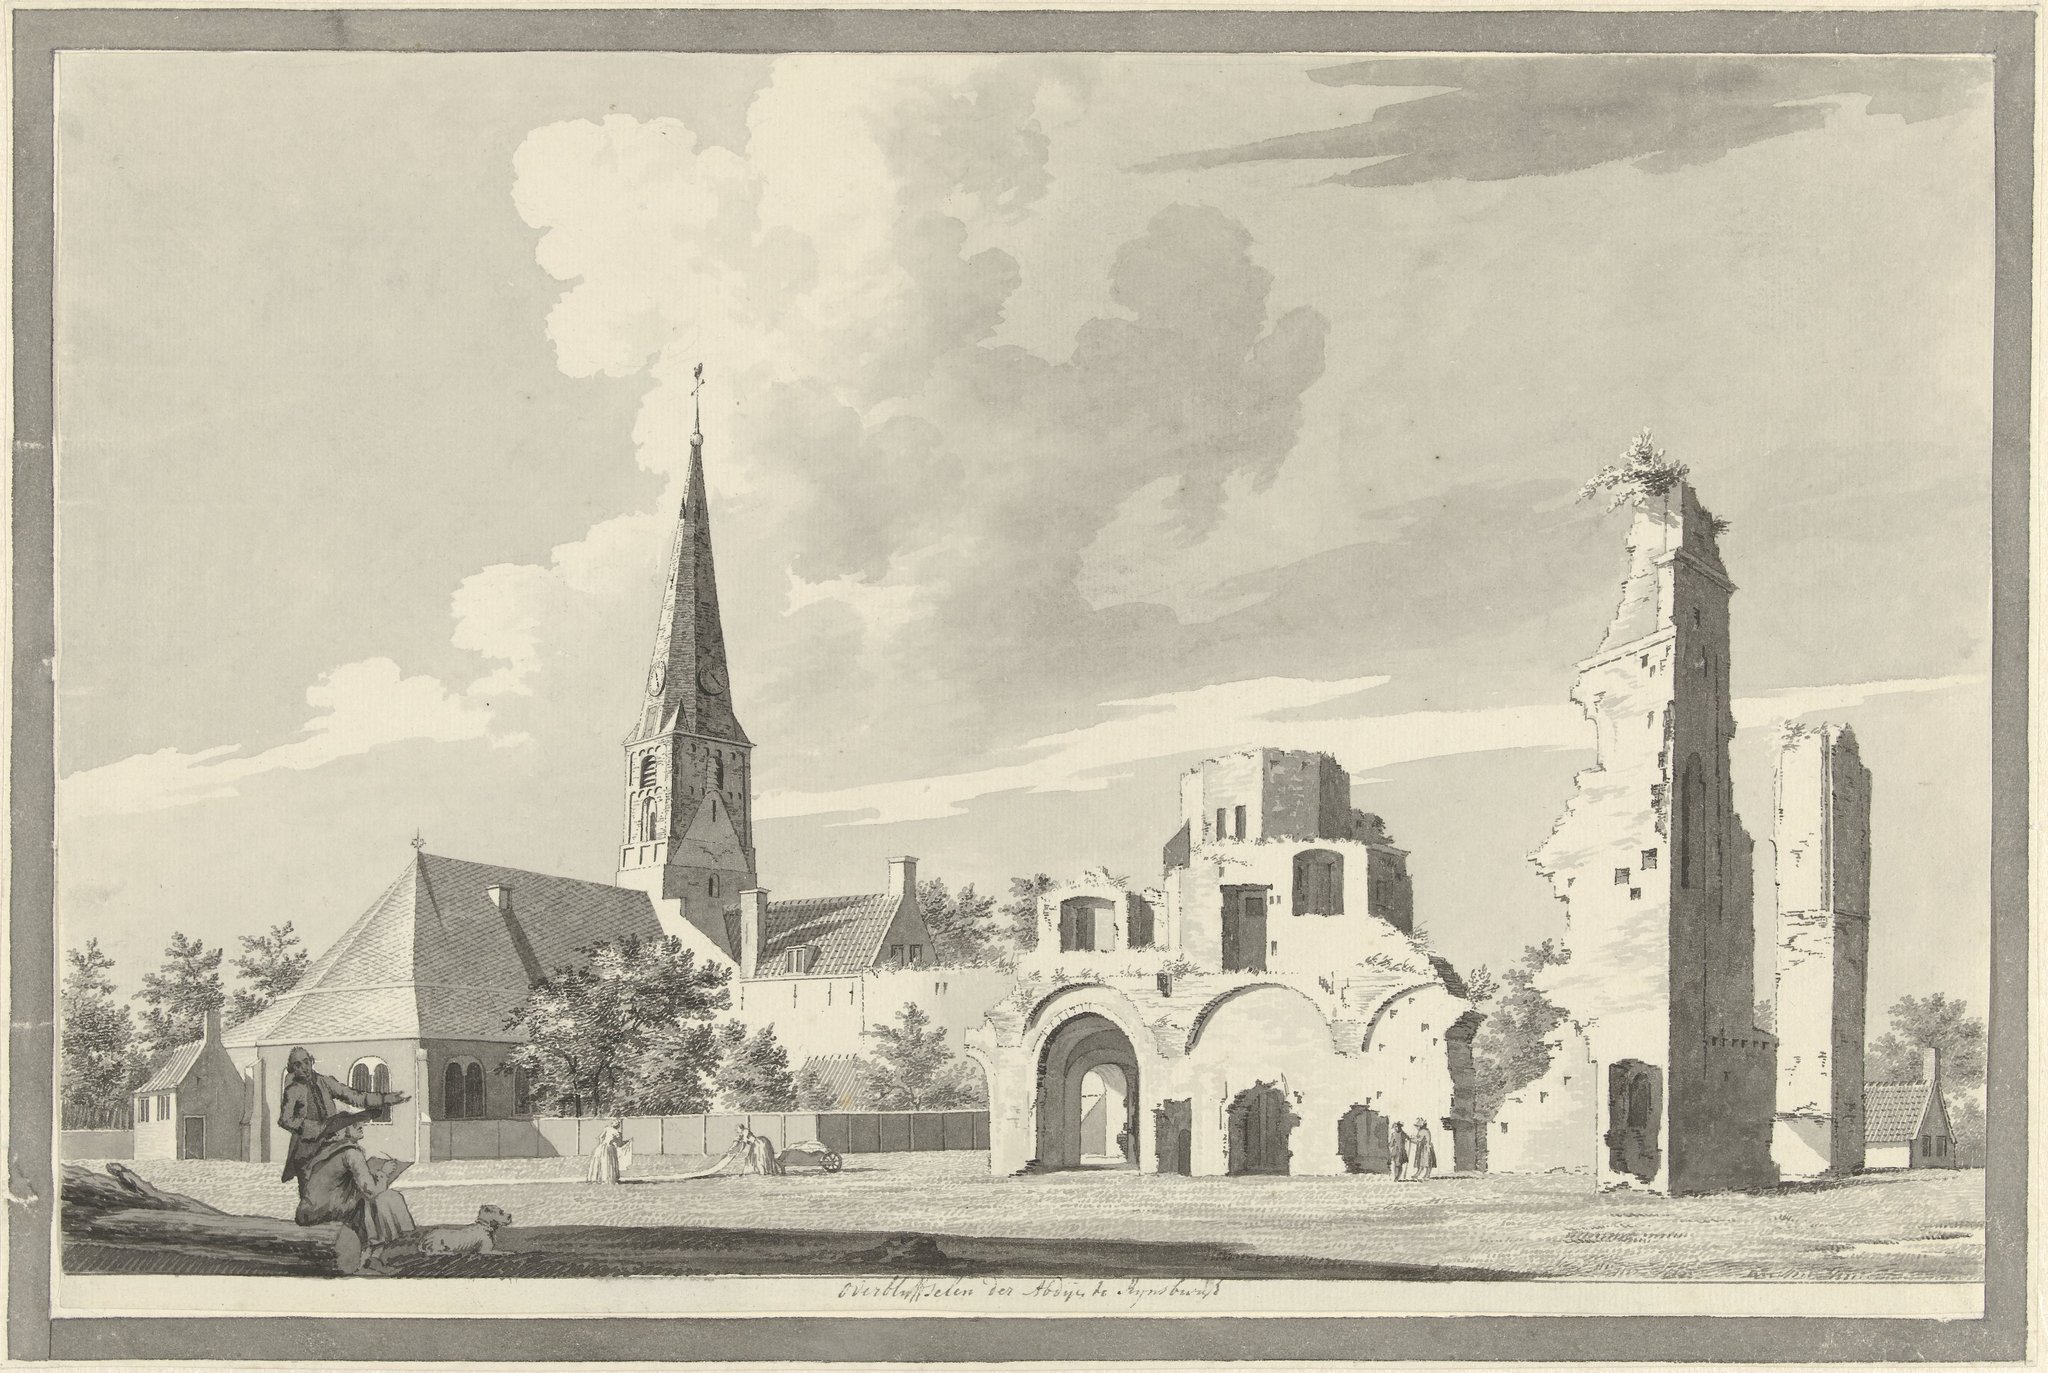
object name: drawing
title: De ruïne van de abdij van Rijnsburg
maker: gerrit toorenburgh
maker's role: draughtsman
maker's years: 1732-1785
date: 1742-1785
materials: ink, paper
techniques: brush, pen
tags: ruin of church, monastery, etc.